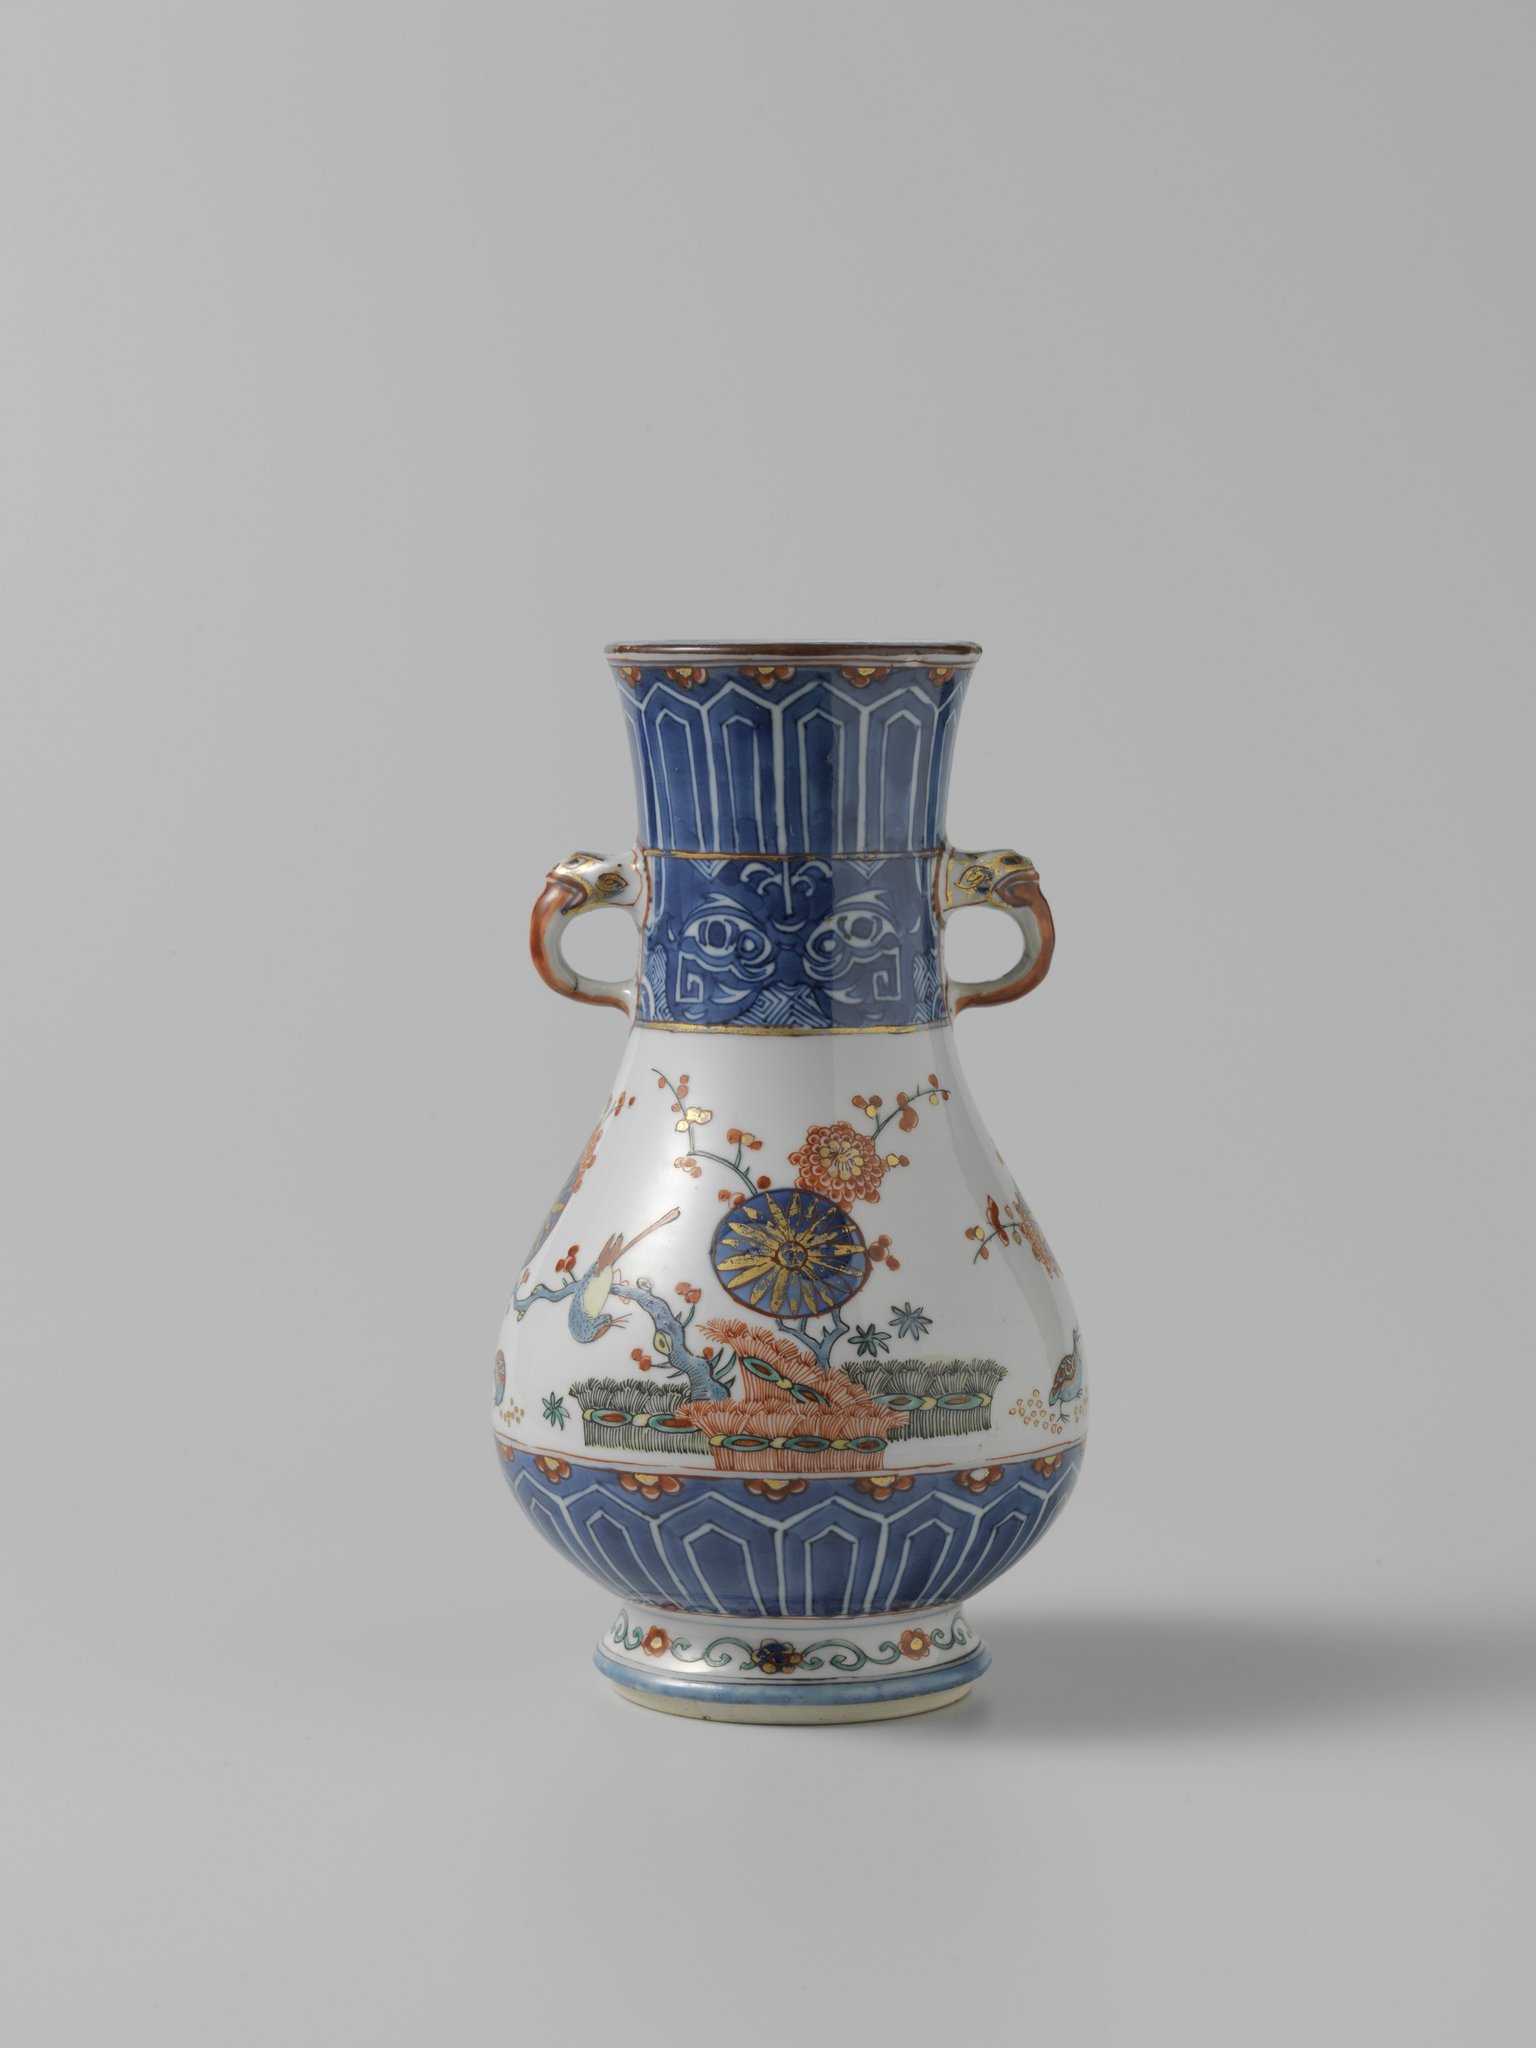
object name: vase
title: Pear-shaped vase with ornamental borders, flowering plants, brushwood fences and birds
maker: Anonymous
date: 1700-1724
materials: cobalt, glaze, gold, paint, porcelain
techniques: firing, gilding, turning, vitrification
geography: china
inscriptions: mark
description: Four vases. China, c. 1690 - 1710, decorated, c. 1710 - 1725.